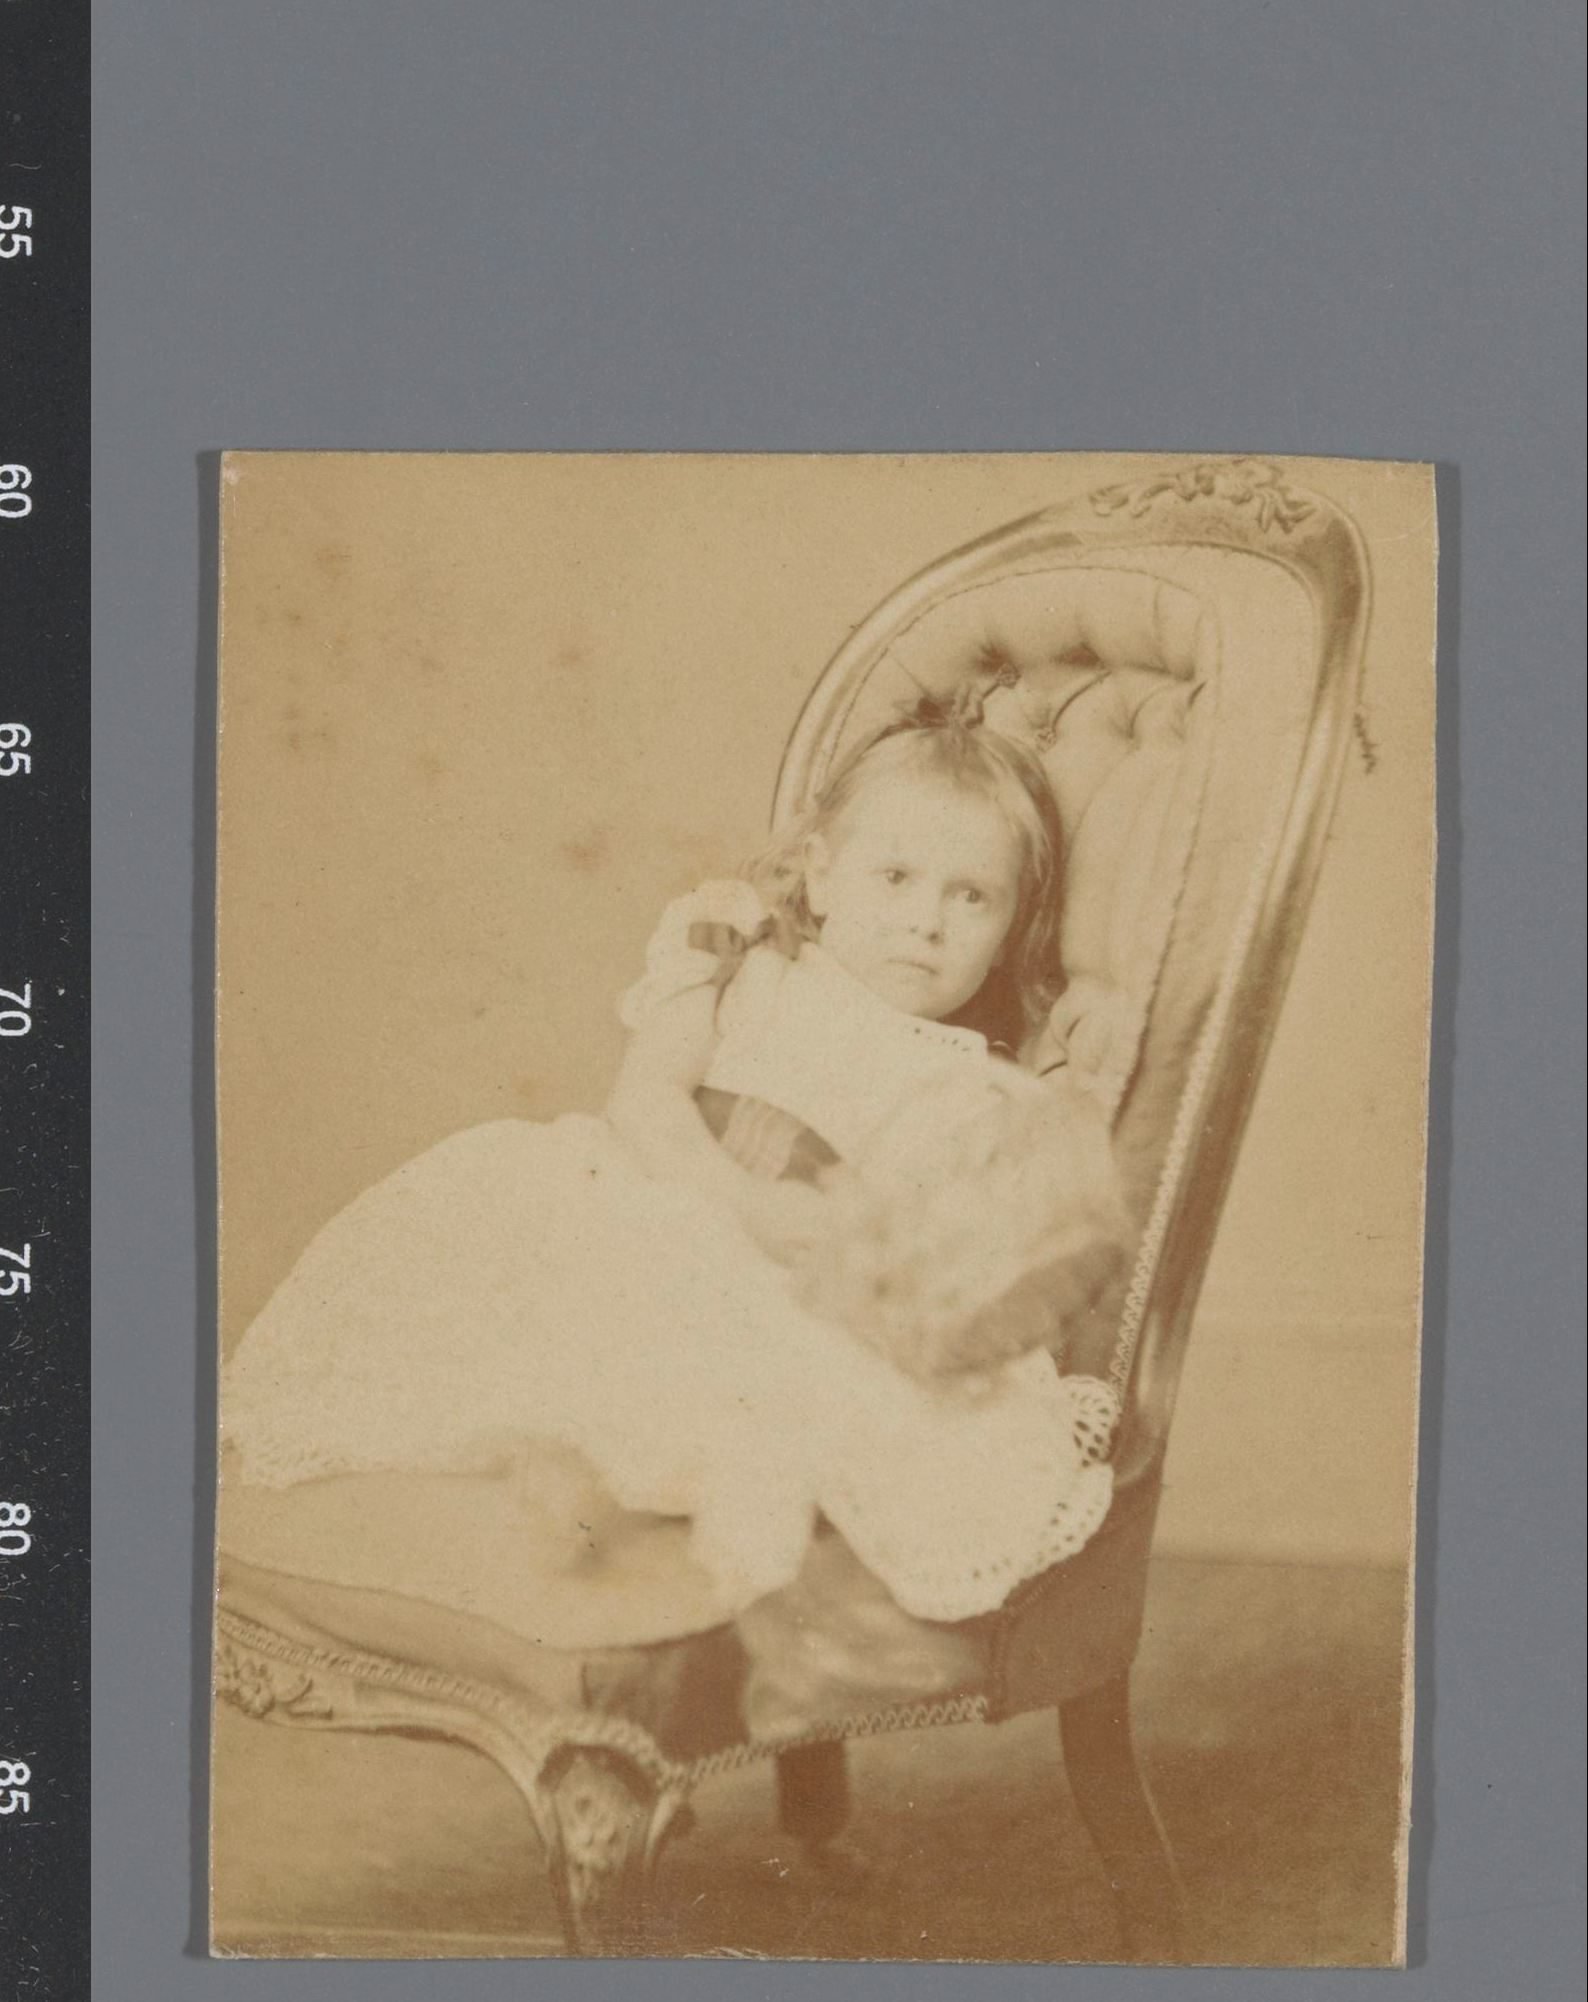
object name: photograph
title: Portret van een onbekend meisje op een stoel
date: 1875-1890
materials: cardboard, photographic support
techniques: albumen print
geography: adelaide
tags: girl (child between toddler and youth), chair